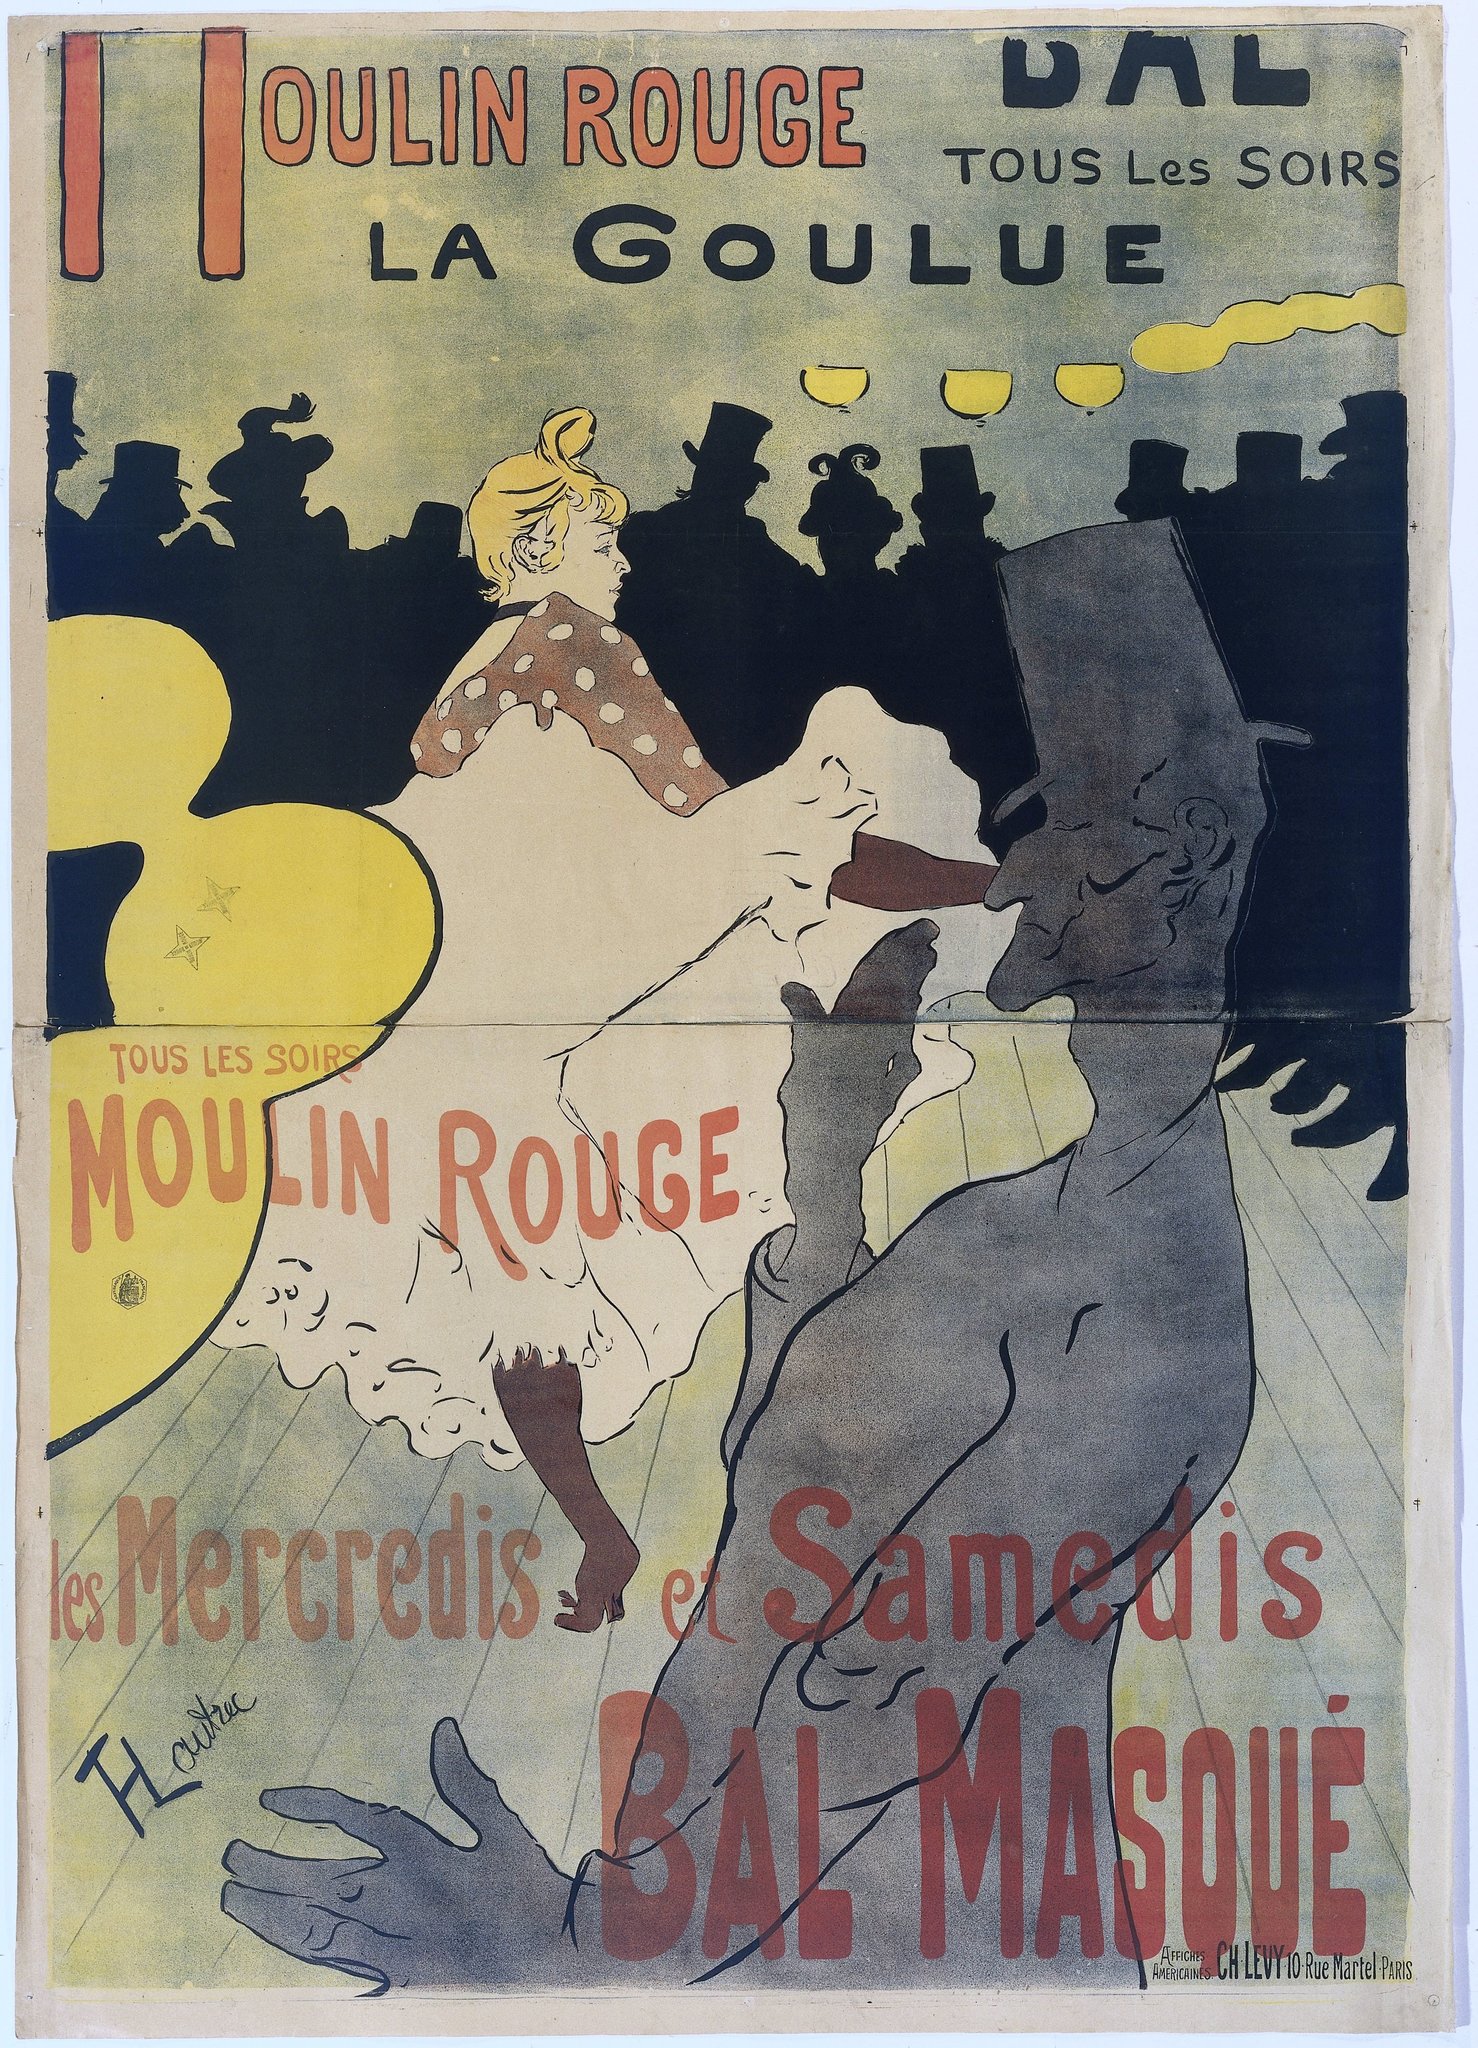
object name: poster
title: Poster for ‘Le Moulin Rouge’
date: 1891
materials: paper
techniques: lithograph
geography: paris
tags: dancing, ball, formal dance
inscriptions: stamp: ‘Moulin Rouge’, stamp: ‘Republique Française’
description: This is Lautrec’s first, and simultaneously most famous, poster. His talent for drawing on stone (lithography) was fully developed at that time. Depicted are the cabaret’s dancing stars ‘La Goulue’ (The Glutton) and her partner ‘Valentin le Désossé’ (The Boneless One). This poster was acclaimed in the French newspapers and shortly thereafter shown in an avant-garde exhibition in Brussels.